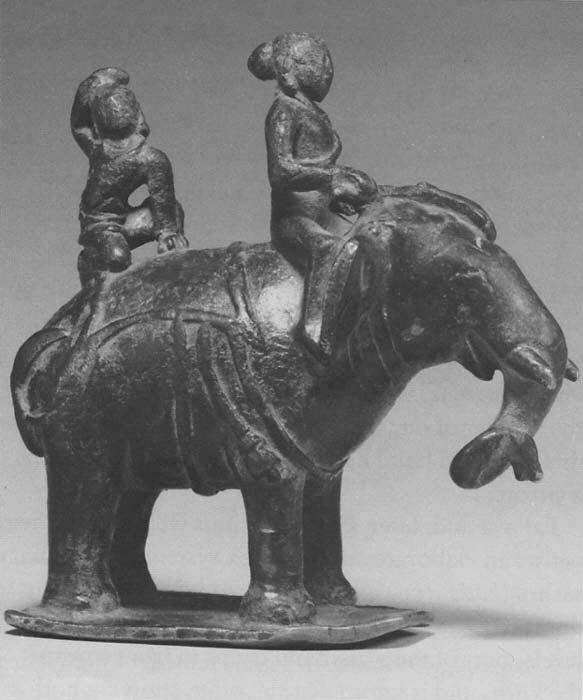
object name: figurine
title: Royal Riders on an Elephant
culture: tamil nadu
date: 1001-1100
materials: copper alloy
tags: men,elephants